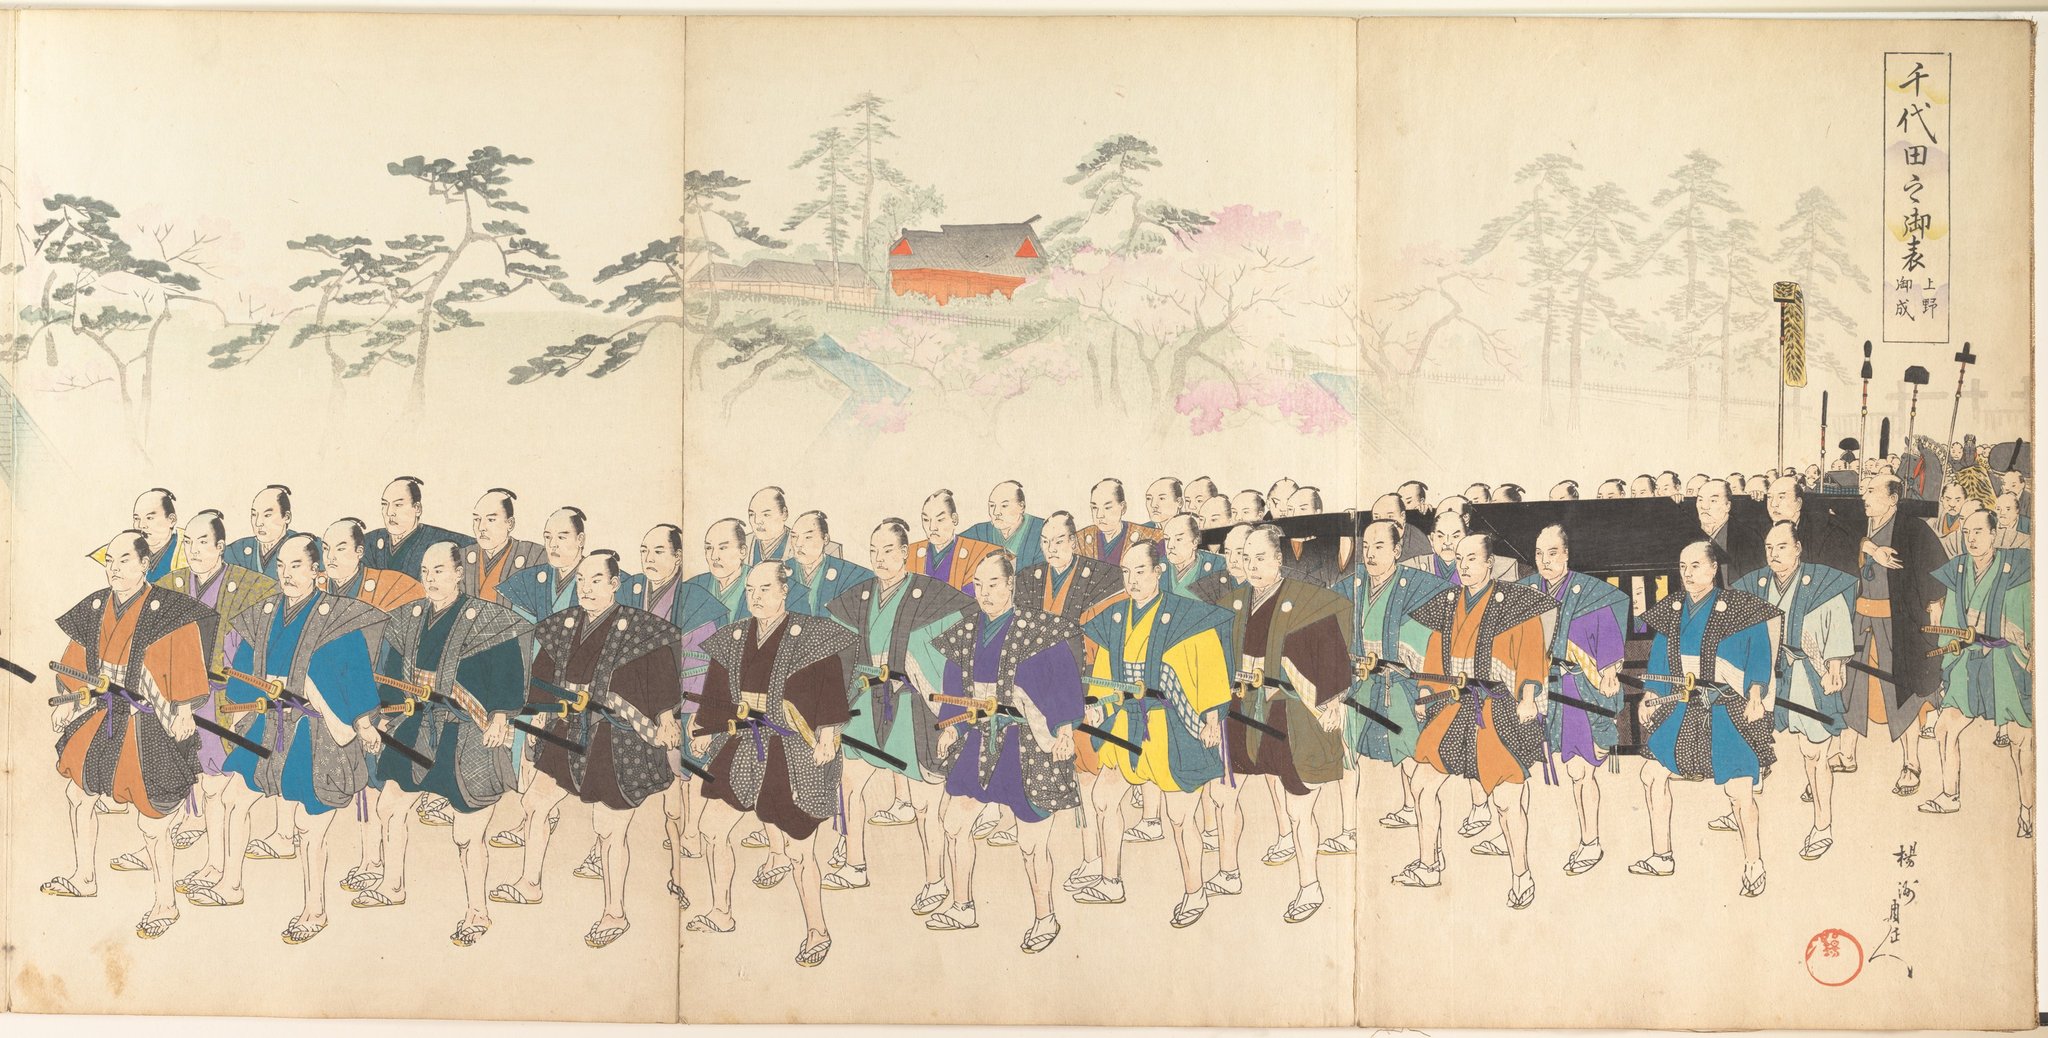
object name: print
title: Chiyoda Castle (Album of Men)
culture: japanese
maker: yōshū (hashimoto) chikanobu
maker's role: artist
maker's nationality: japanese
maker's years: 1838-1912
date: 1897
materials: ink, paper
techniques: woodblock print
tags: swords,men,crowd